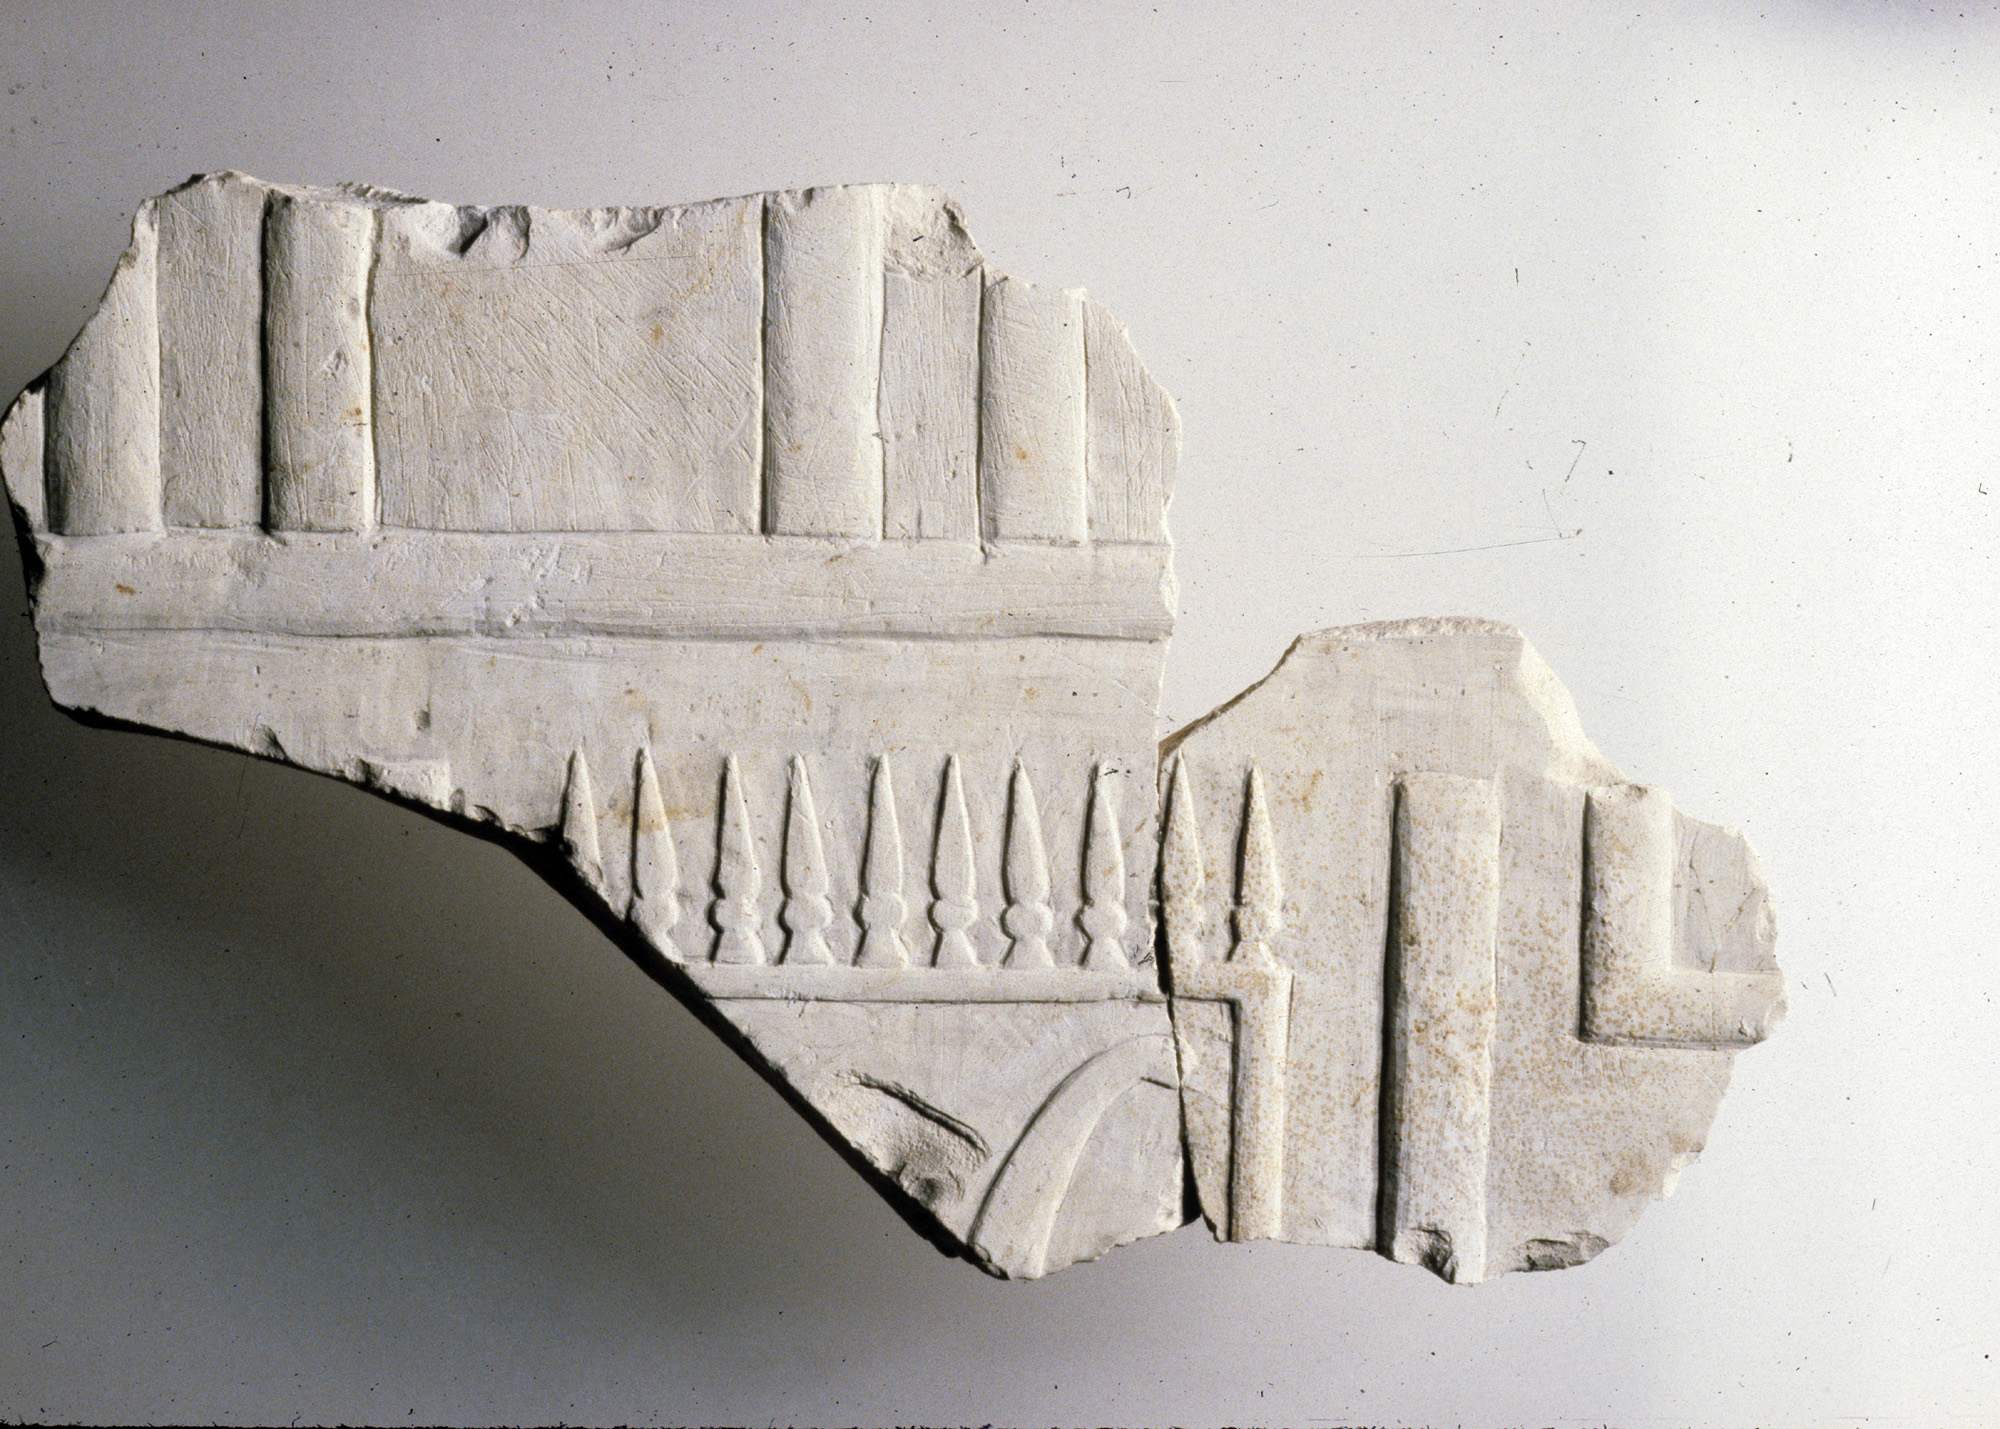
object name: relief fragment, tomb of meketre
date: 1981-1975 BCE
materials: limestone, paint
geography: egypt